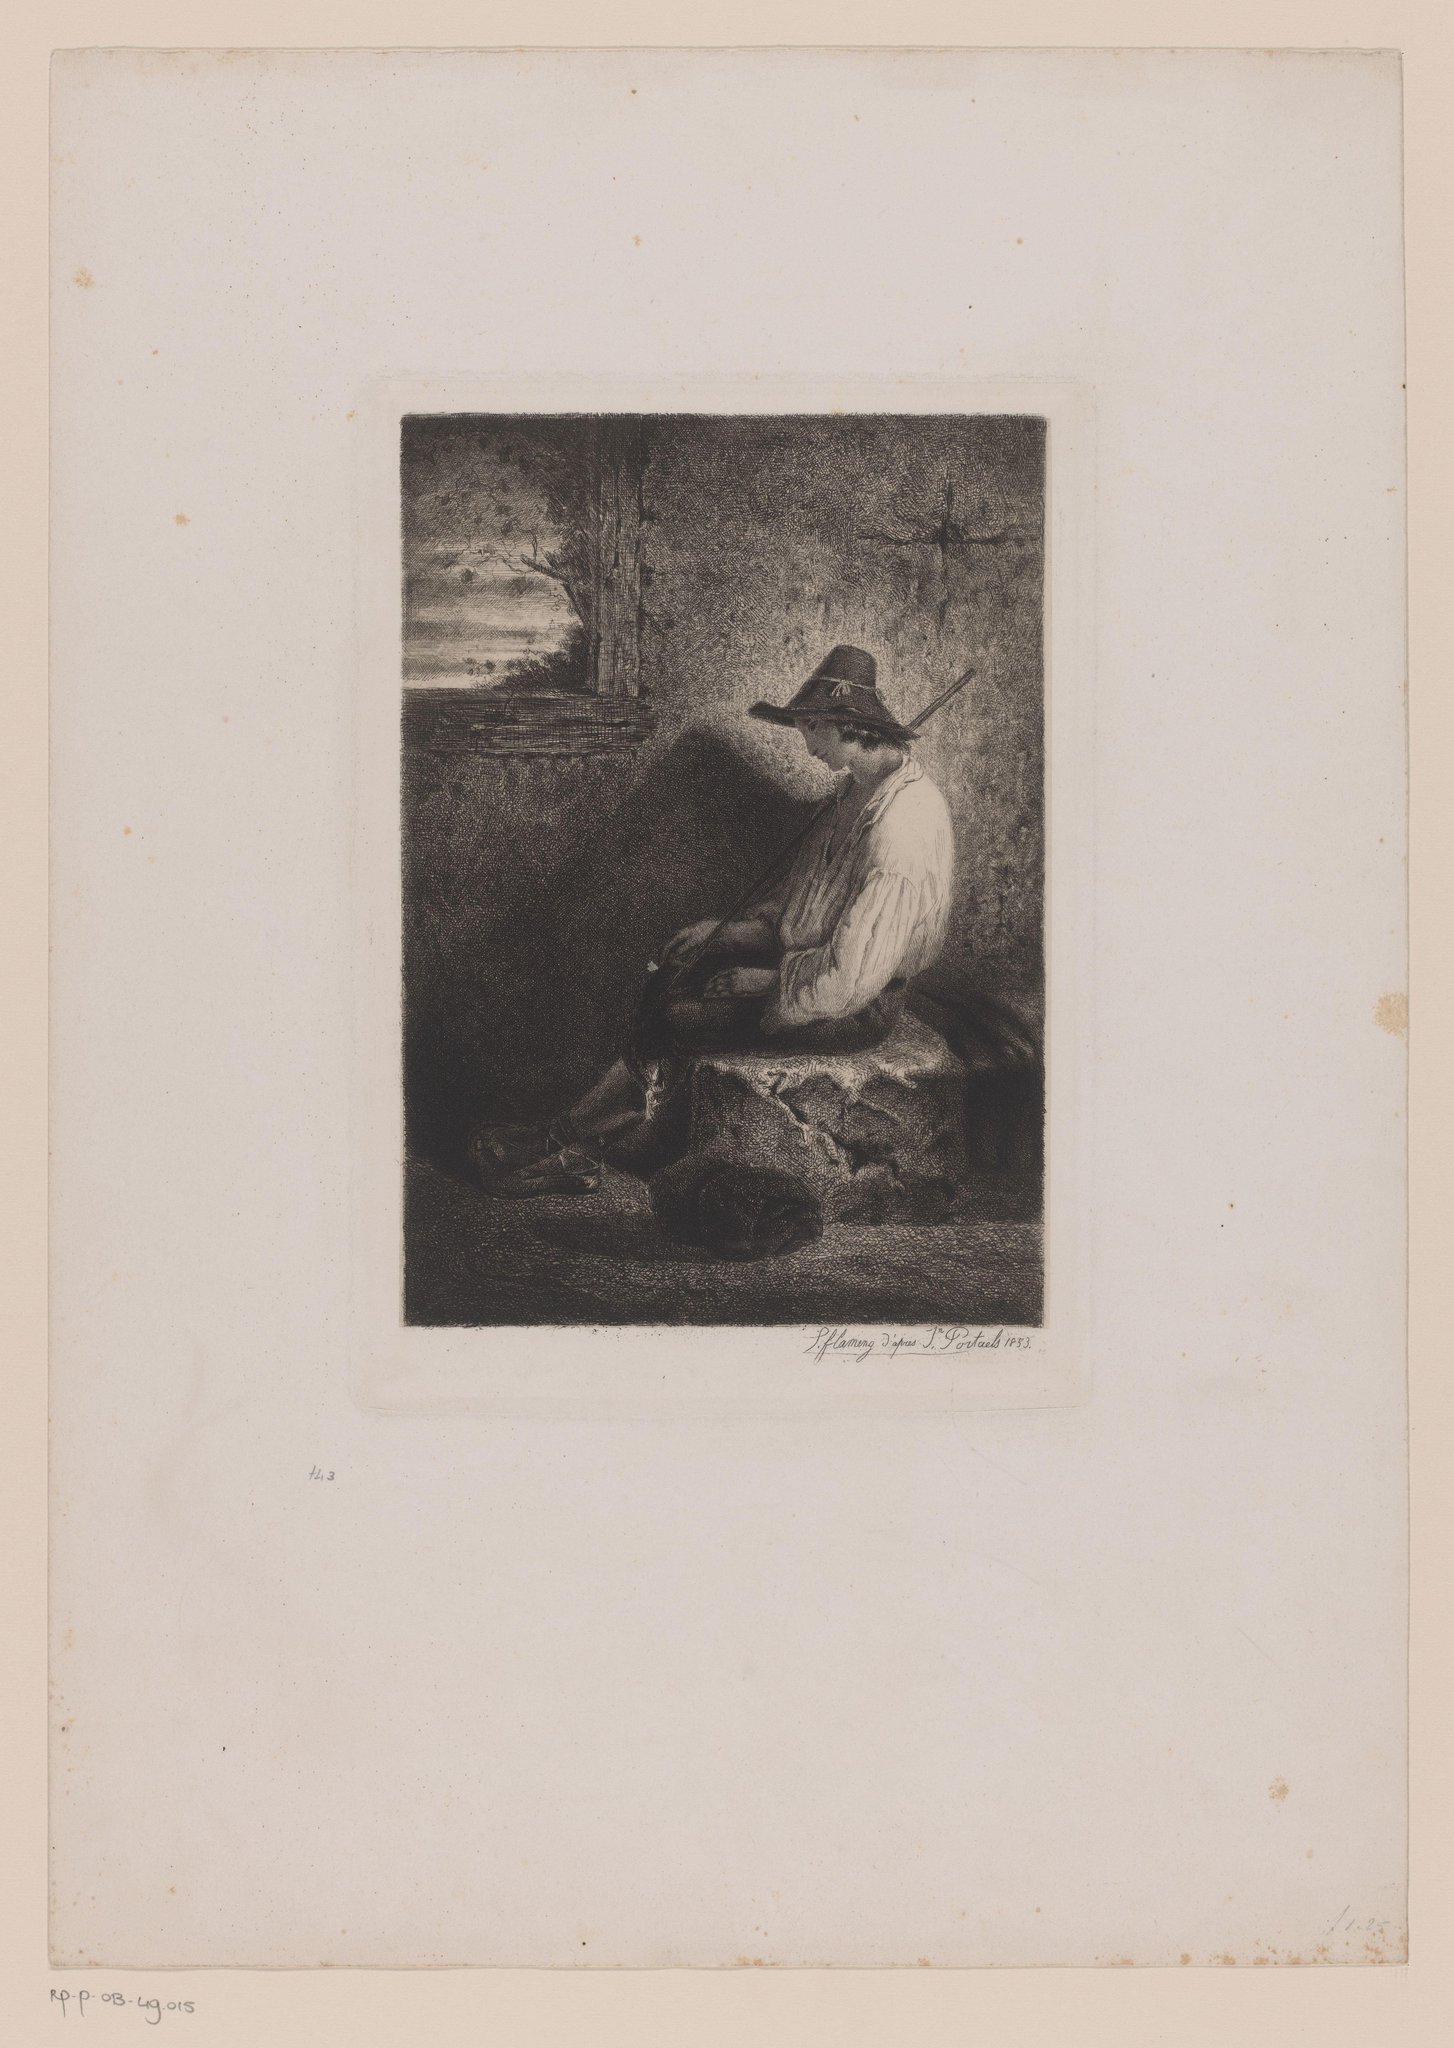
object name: print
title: Rustende herder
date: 1853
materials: paper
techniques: etching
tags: herding, herdsman, herdswoman, shepherd, shepherdess, cowherd, etc.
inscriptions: collector's mark: Lugt 2228